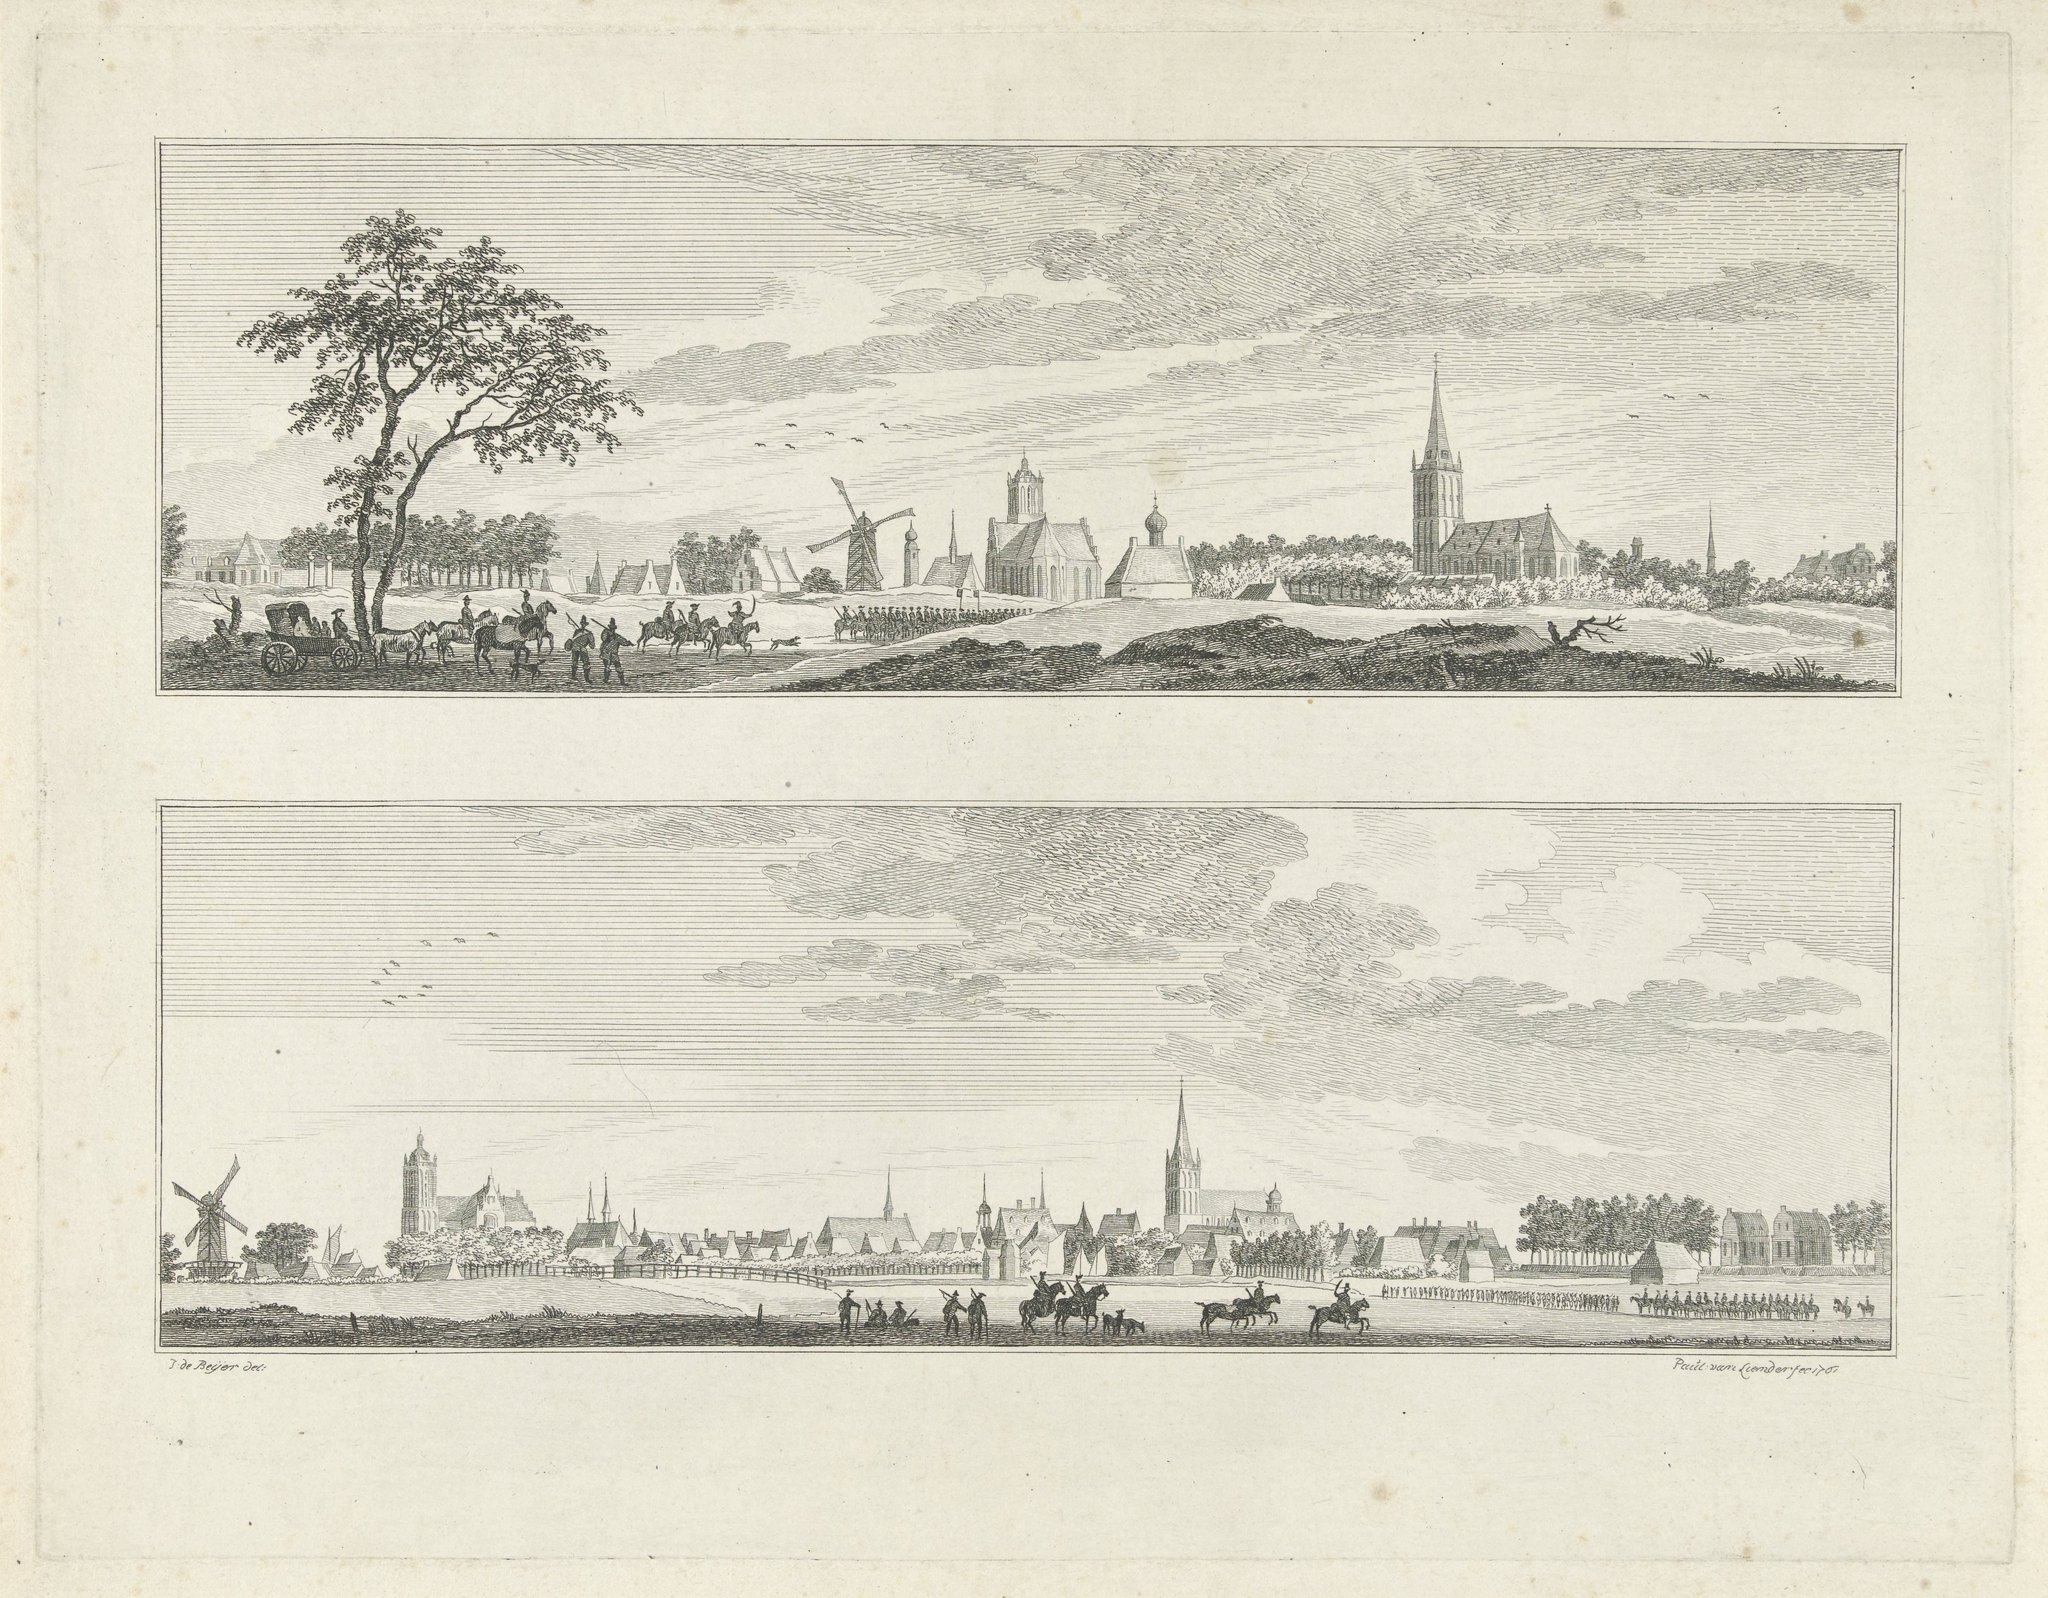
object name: print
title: Gezichten op Wezel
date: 1761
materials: paper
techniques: etching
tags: army 'en route', prospect of city, town panorama, silhouette of city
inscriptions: collector's mark: Lugt 2228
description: Twee gezichten op de Duitse stad Wezel (Wesel), gezien vanuit de omliggende landerijen waar soldaten zich te voet en te paard richting de stad begeven. Twee voorstellingen van één plaat.